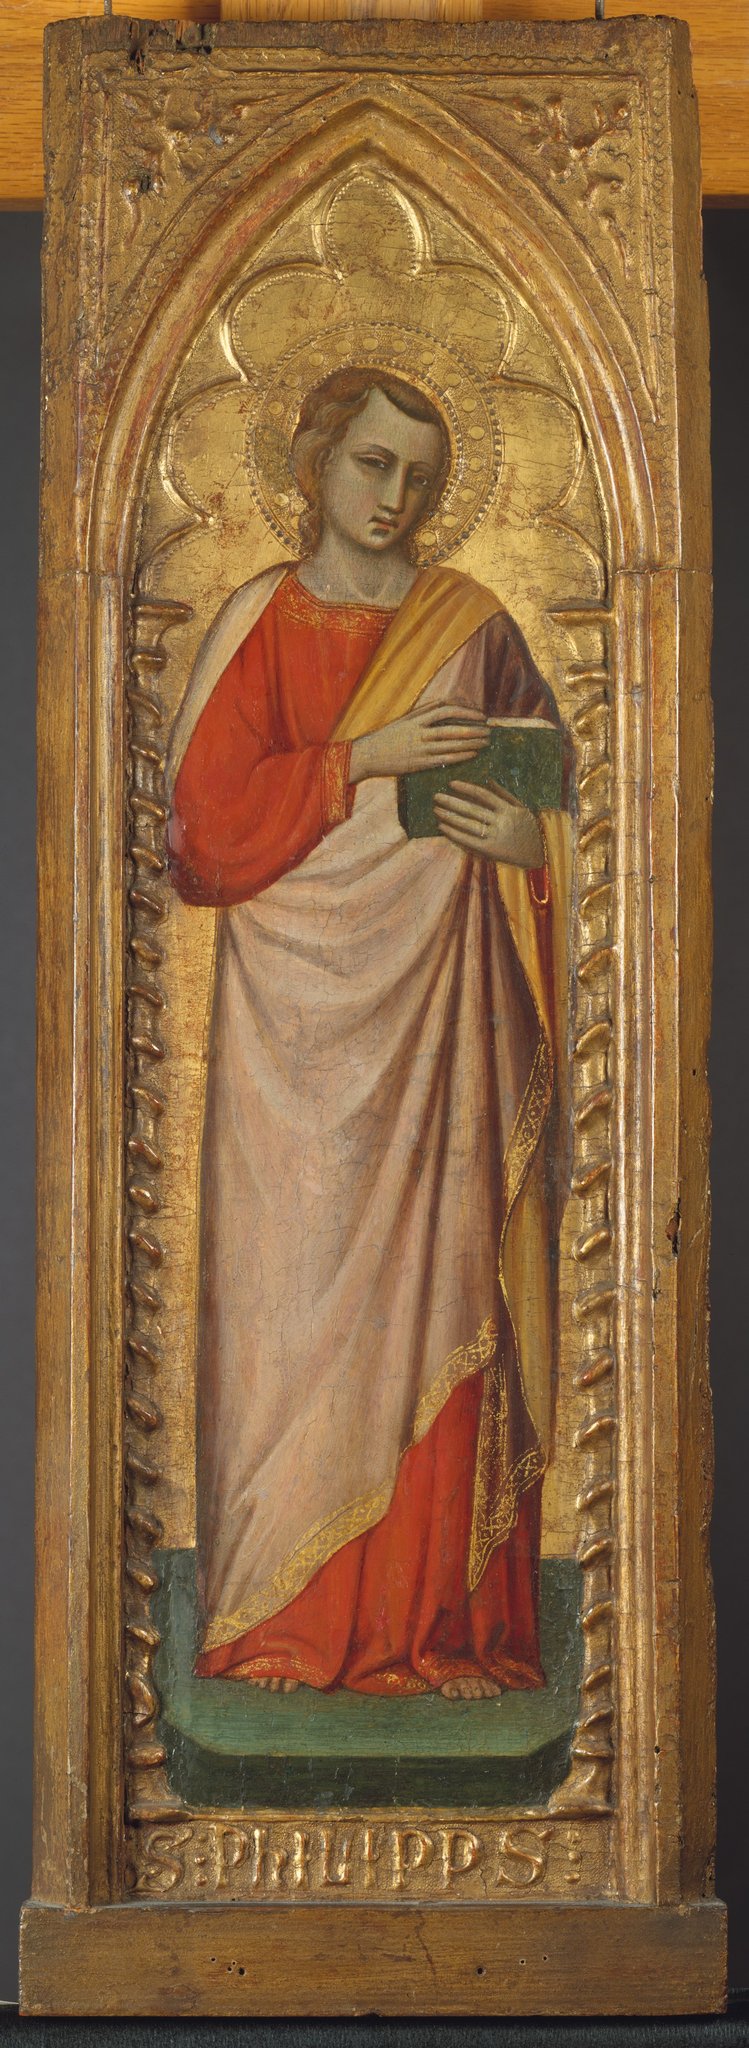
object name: painting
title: Saint Philip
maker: spinello aretino (spinello di luca spinelli)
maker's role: artist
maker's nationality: italian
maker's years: 1345-1410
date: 1384-1385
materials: gold, paint, wood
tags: men,saints